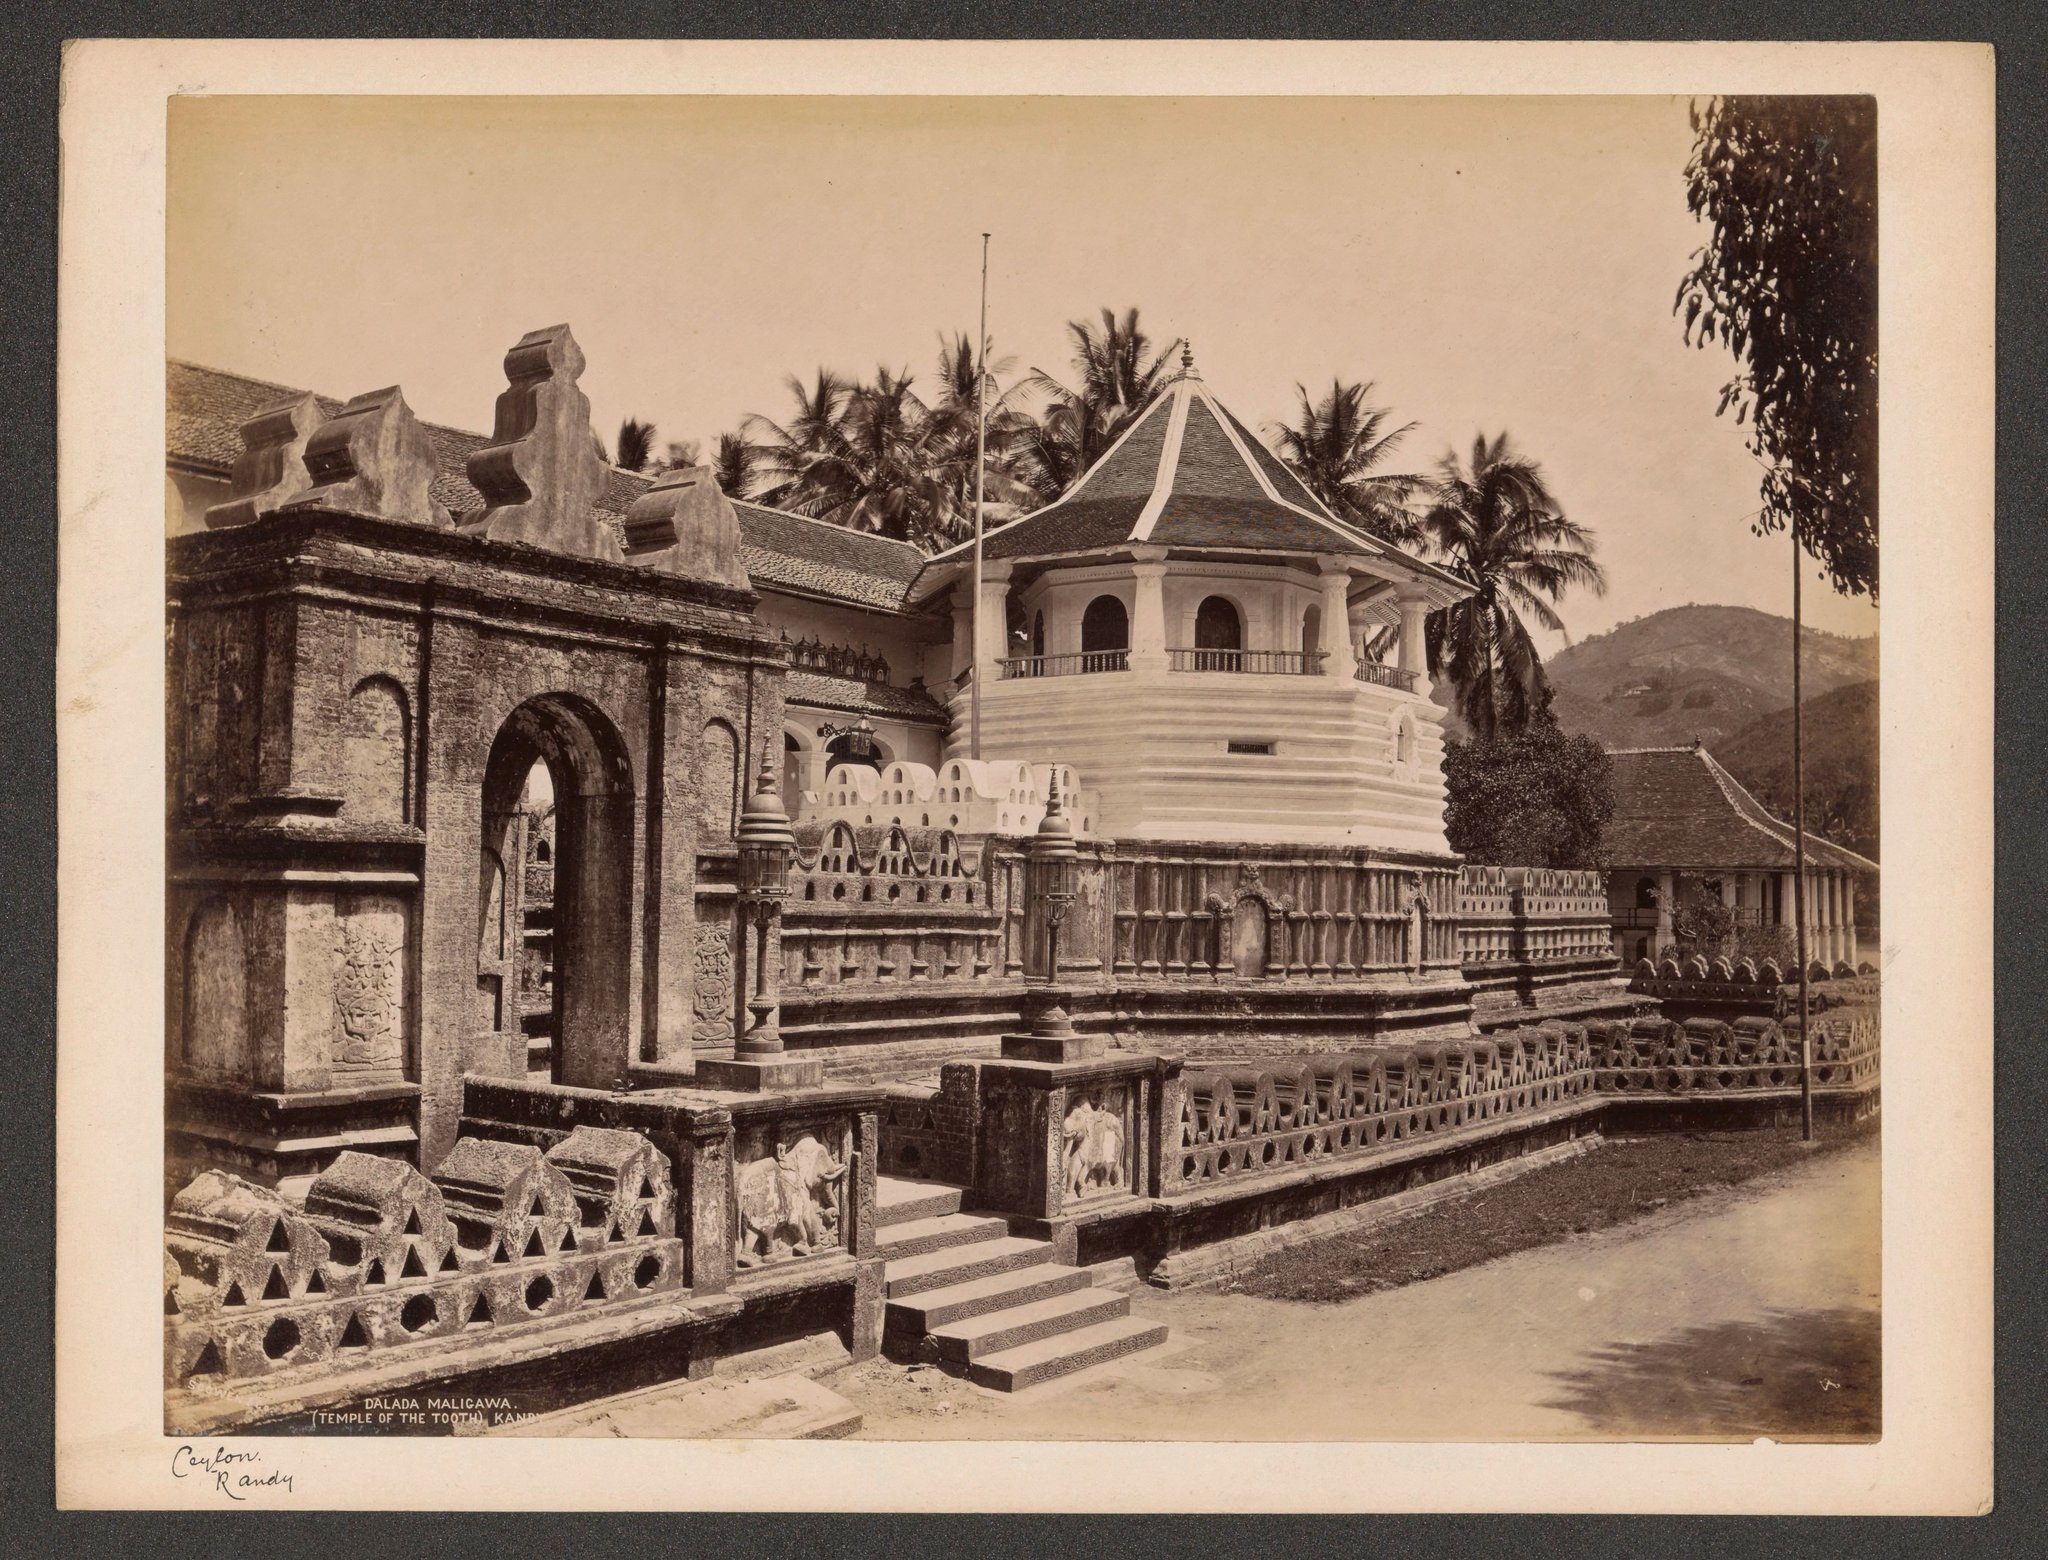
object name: photograph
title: Exterior of Sri Dalada Maligawa or the Temple of the Holy Tooth, Kandy, Sri Lanka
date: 1876-1893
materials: cardboard, paper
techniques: albumen print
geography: kandy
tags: temple, shrine ~ hinduism, buddhism, jainism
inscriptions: number: ‘31’, inscription: ‘Ceylon./ Kandy’, title: ‘Dalada Maligawa./ (Temple of the Tooth) Kandy.’, signature: ‘Scowen & Co.’